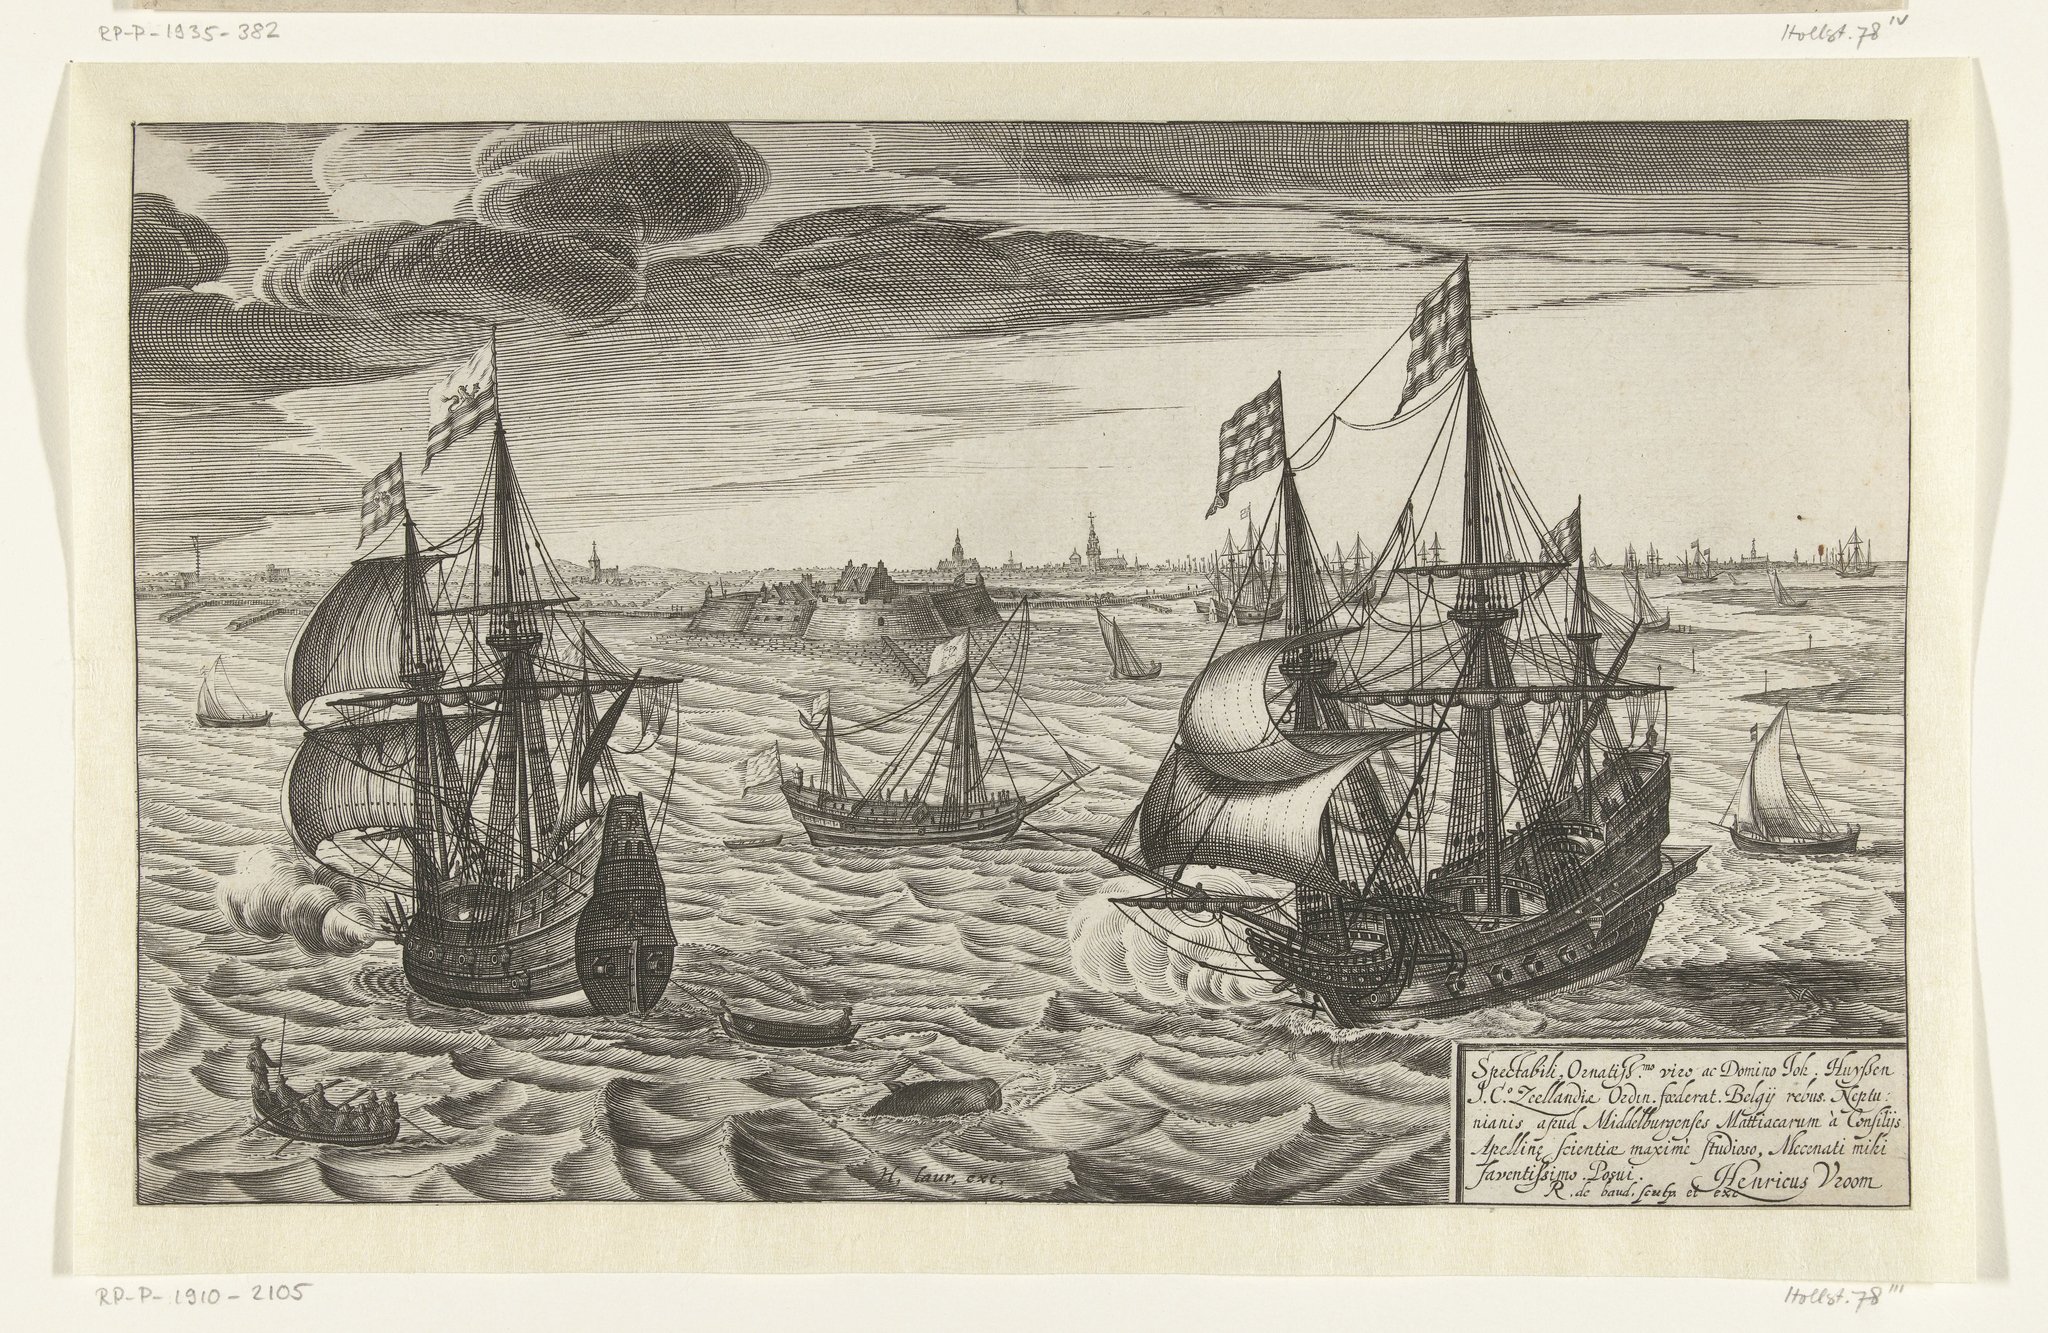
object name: print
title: Marine met gezicht op het fort van Rammekens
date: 1591-1659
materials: paper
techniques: engraving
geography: northern netherlands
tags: warfare; military affairs (+ naval force)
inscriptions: collector's mark: Lugt 2228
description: Zeevloot met gezicht op het fort van Rammekens, met Middelburg en Veere op de achtergrond.